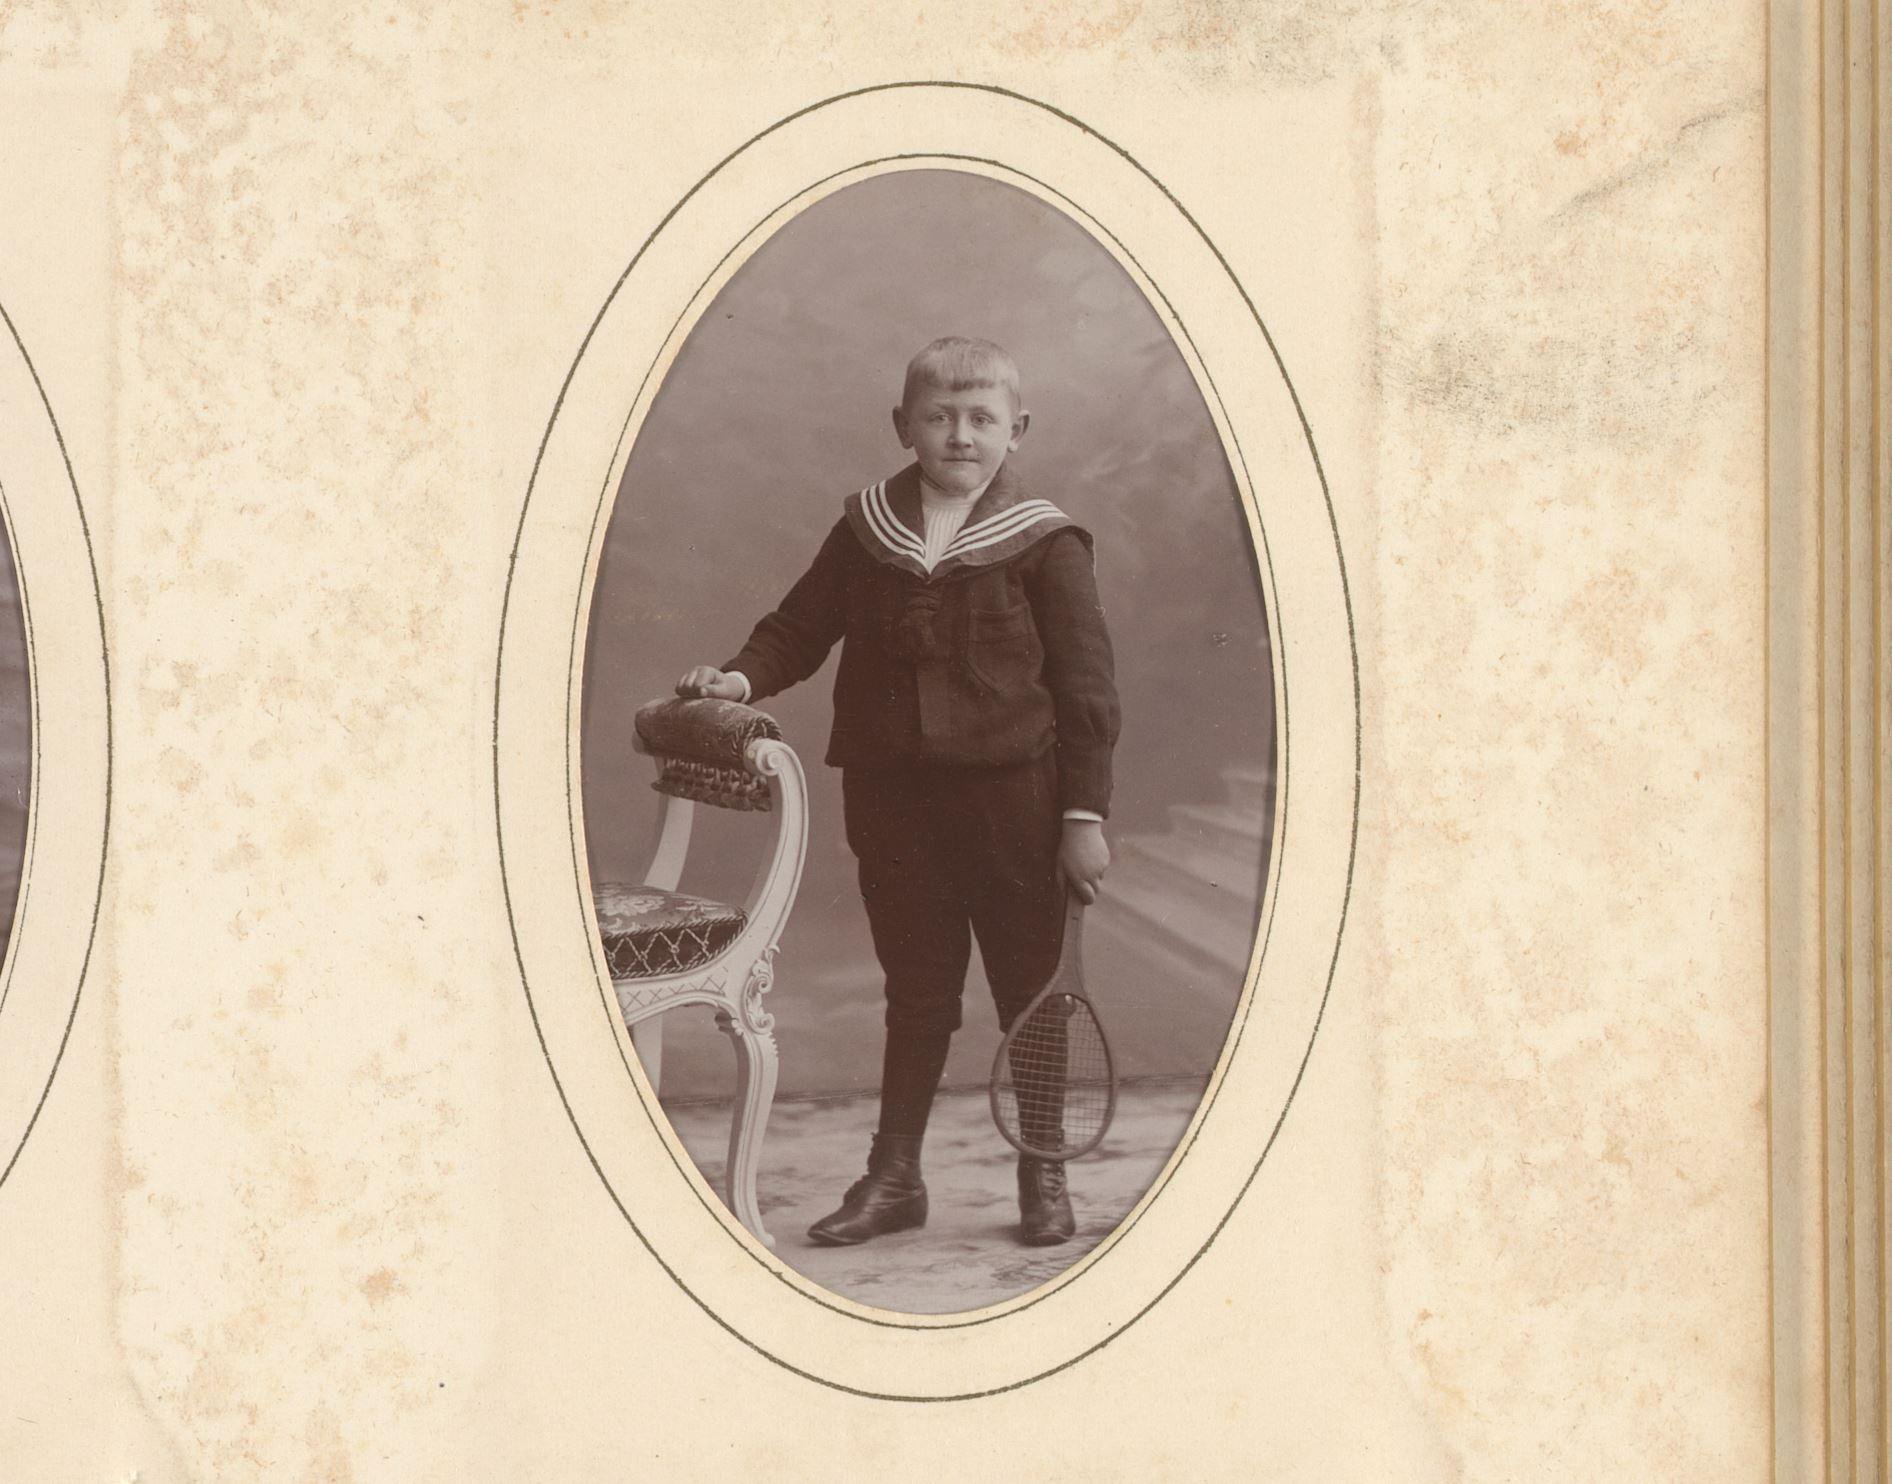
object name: carte de visite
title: Portret van een jongen met tennisracket in de hand, staand bij een stoel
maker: machiel hendricus laddé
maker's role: fotograaf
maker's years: 1866-1932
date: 1892-1906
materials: cardboard, photographic support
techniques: collodion silver print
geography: amsterdam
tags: boy (child between toddler and youth), historical persons, chair, ball games in which ball is hit with racket (or hand)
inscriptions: inscription: ‘M. H. Laddé/ Amsterdam,/ 57-59 Nieuwendijk.’, annotation: ‘Bonneveld./ 6 mè[t]/ heel/ [b]e[..]/ H.’